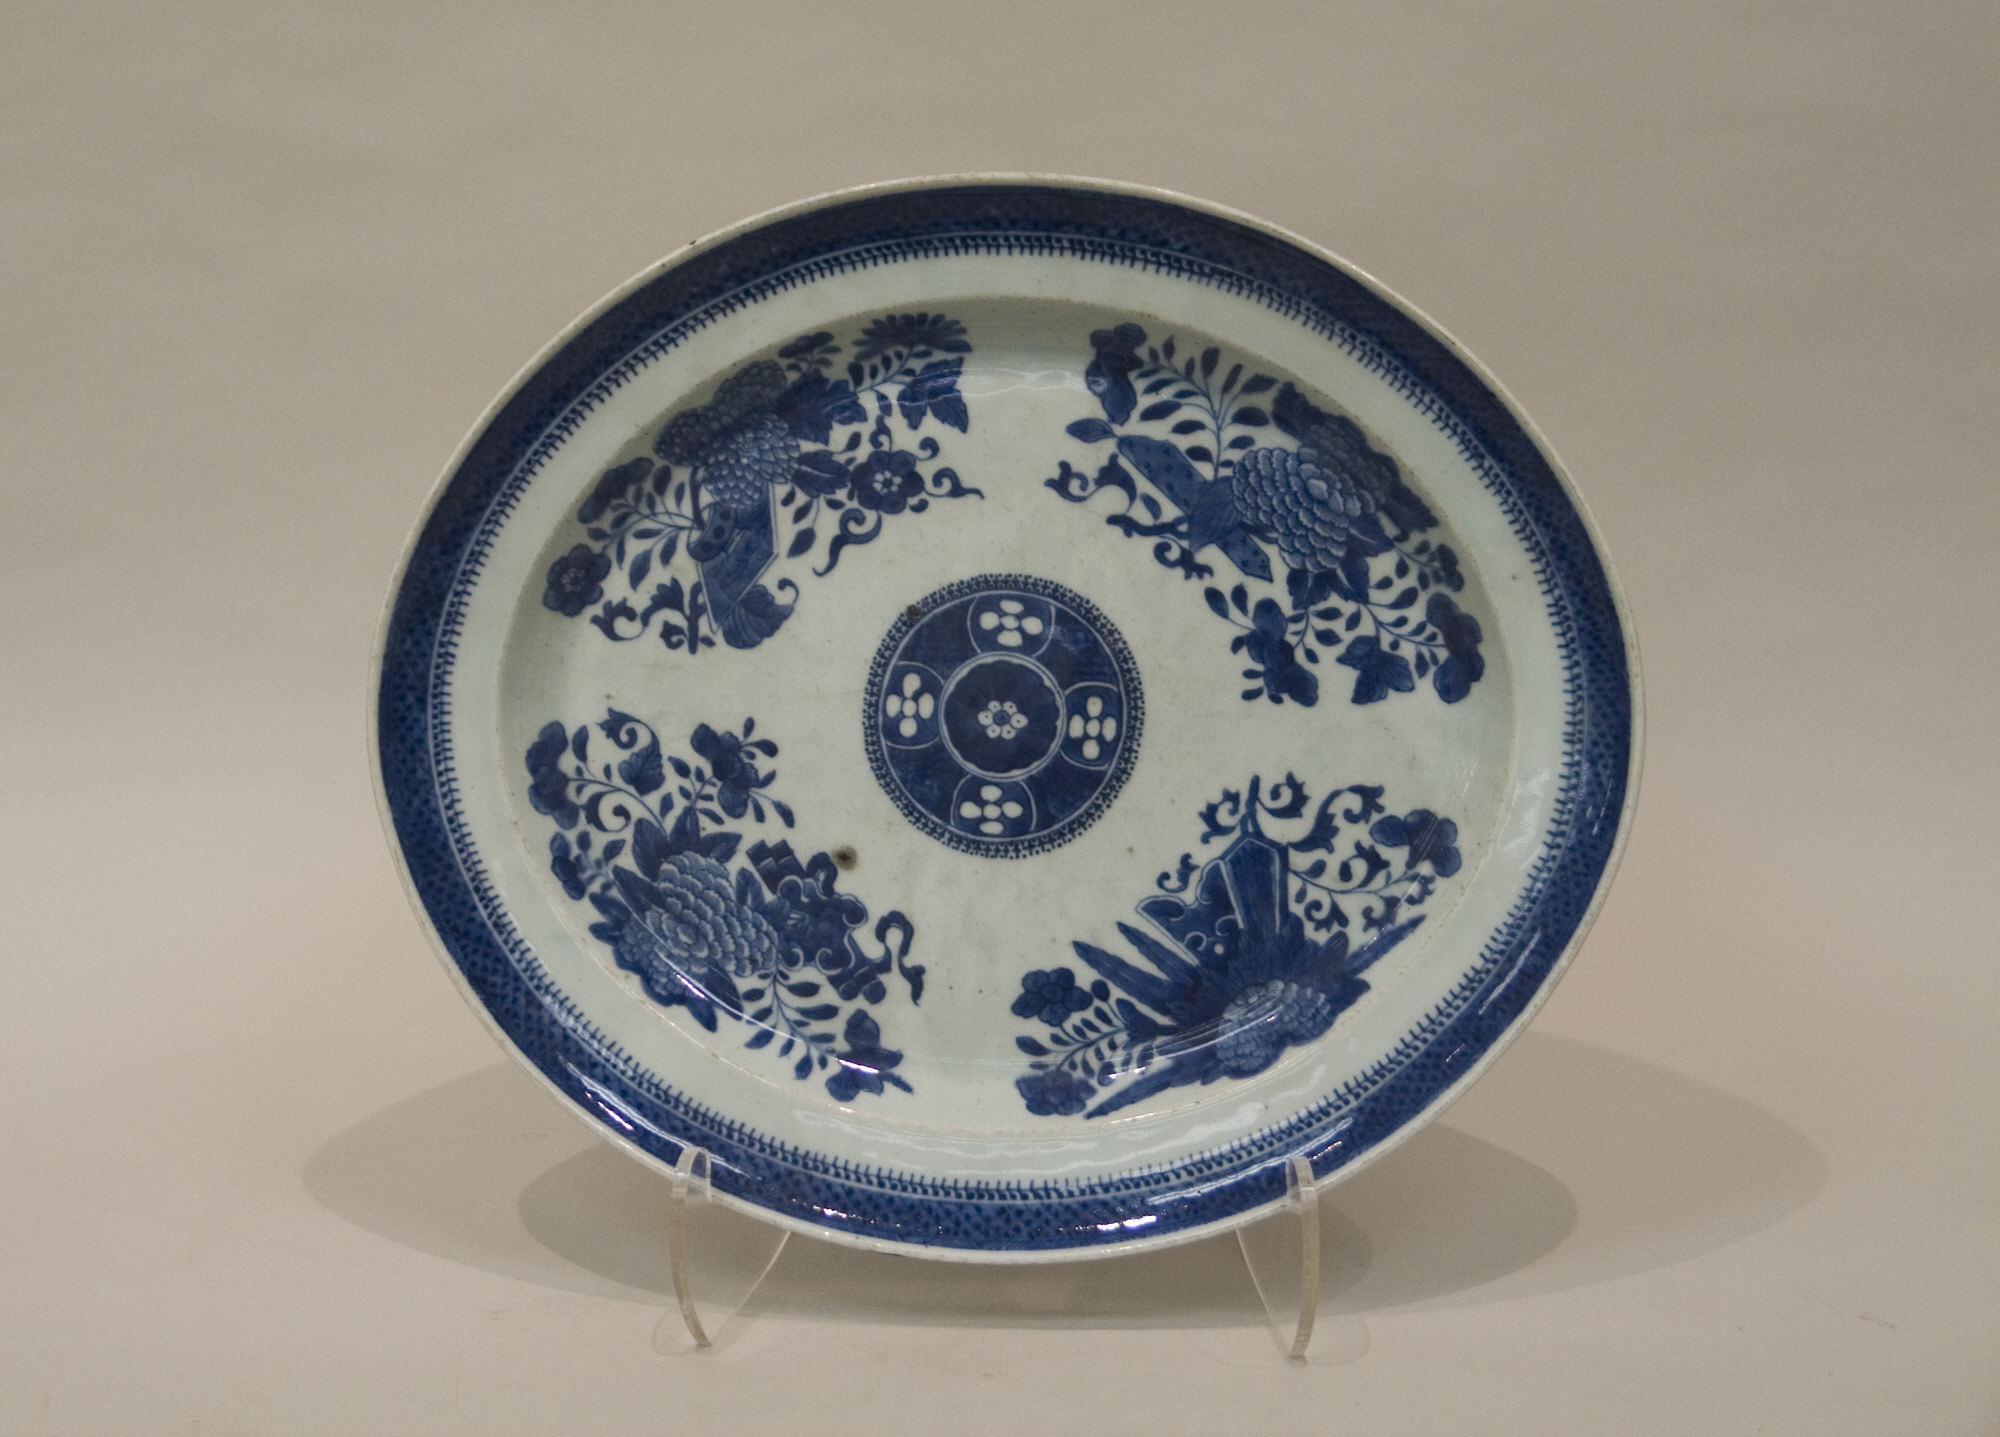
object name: platter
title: Oval Platter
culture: chinese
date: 1801-1900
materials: porcelain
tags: flowers,leaves